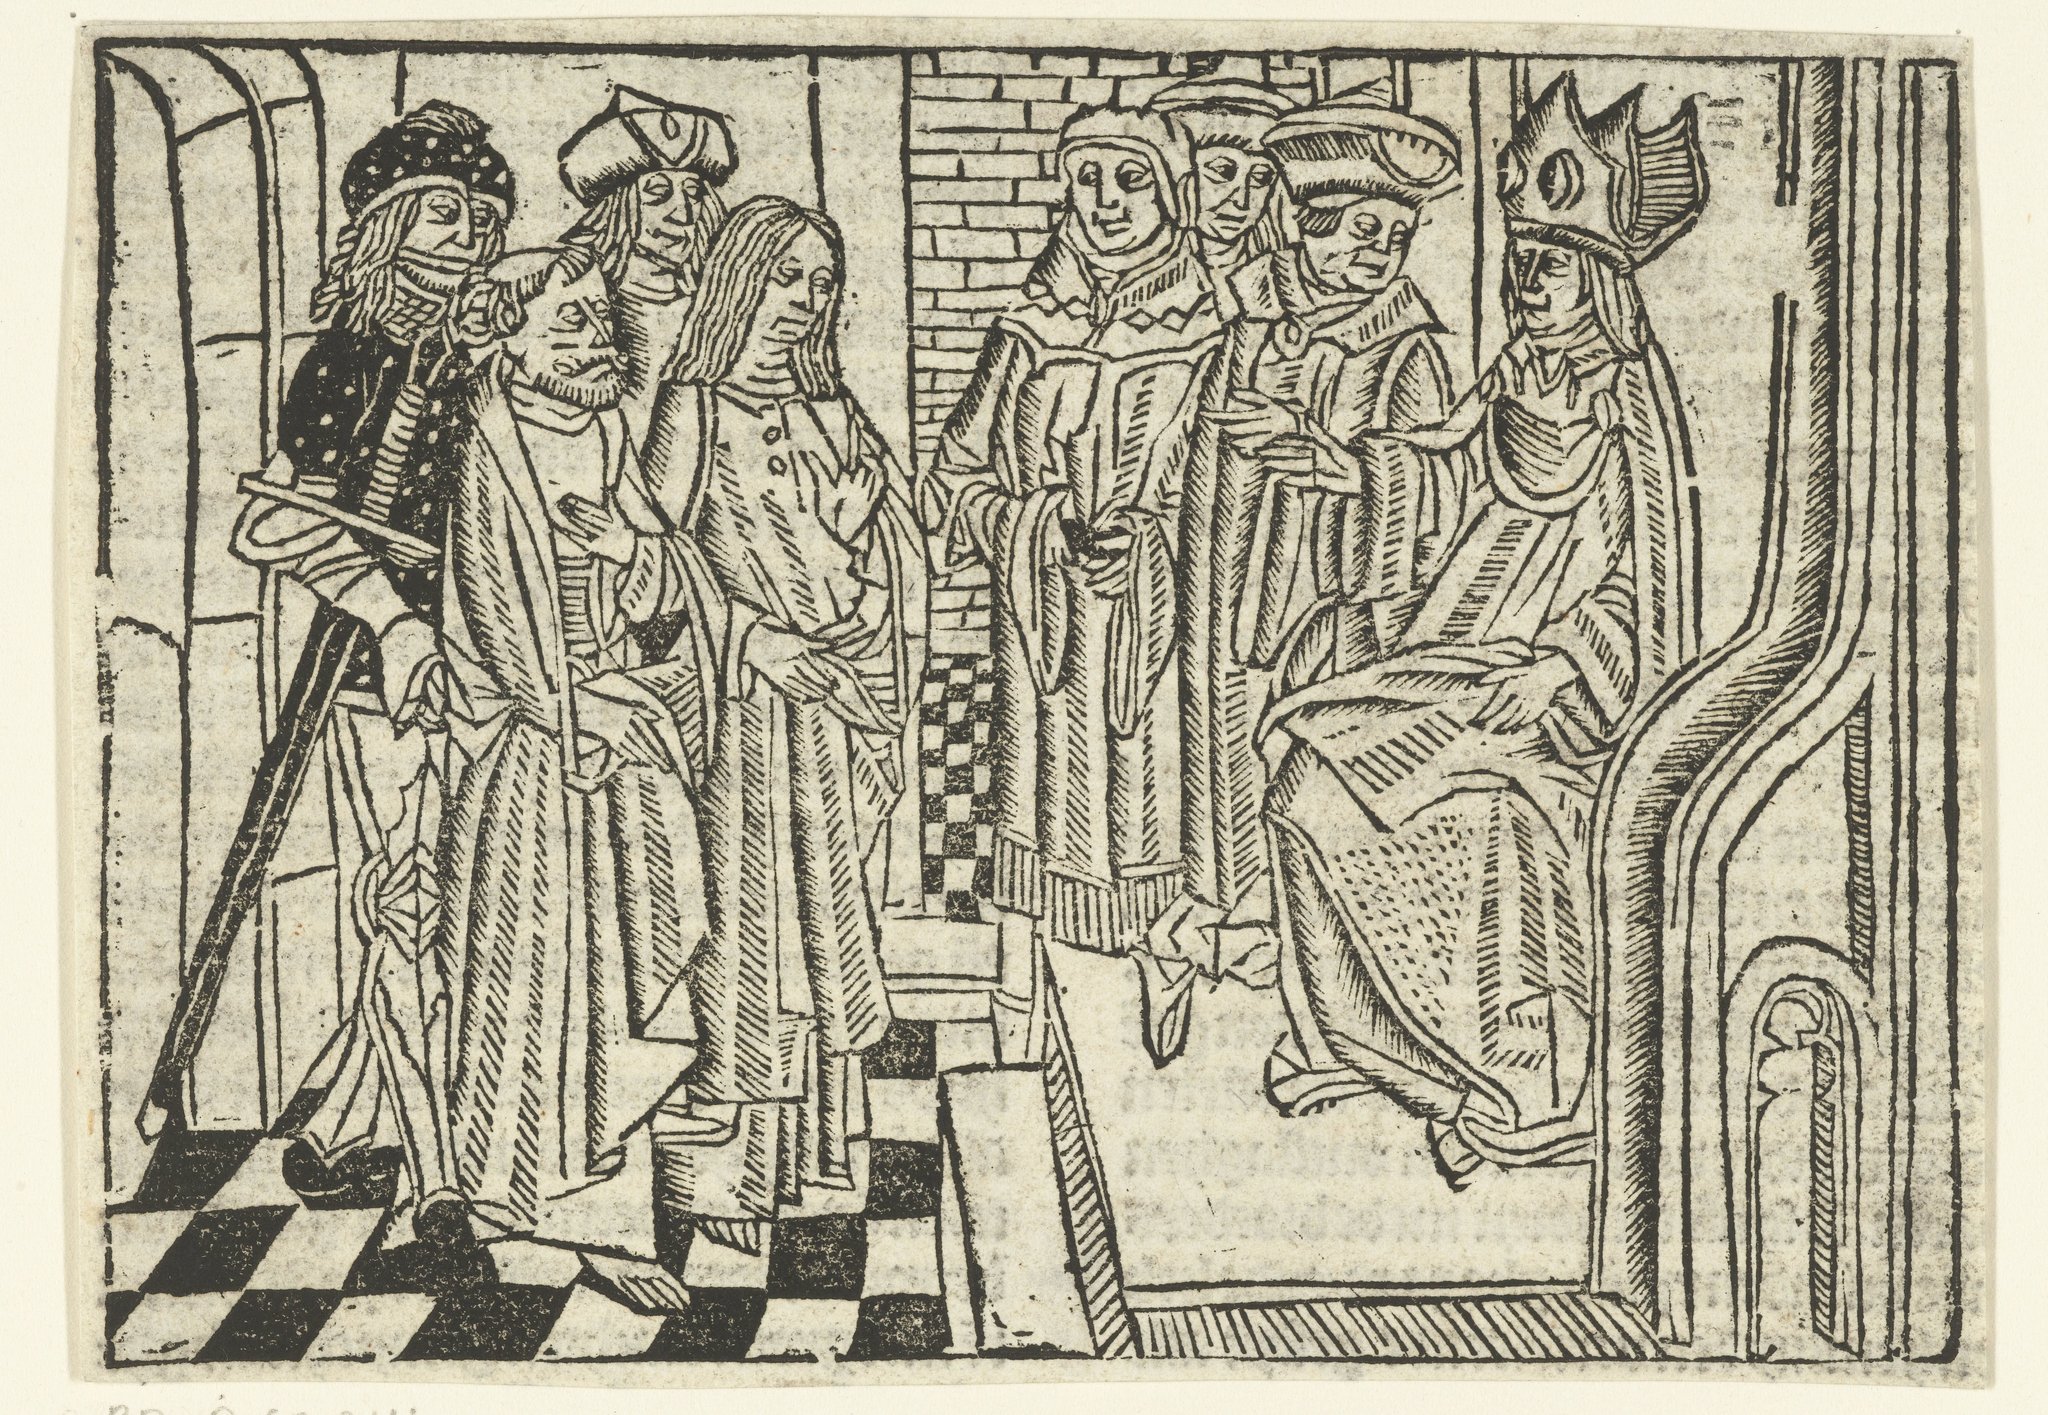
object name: book illustration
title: Petrus en Johannes de evangelist voor de hogepriester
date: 1480-1500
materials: paper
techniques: woodcut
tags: the apostle john the evangelist; possible attributes: book, cauldron, chalice with snake, eagle, palm, scroll, the apostle peter, first bishop of rome; possible attributes: book, cock, (upturned) cross, (triple) crozier, fish, key, scroll, ship, tiara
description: Eén blad van 113 uit Ludolphus de Saxonia, "Dit es dleué ons liefs heeren ihesu christi". Anonieme Nederlandse vertaling. Uitgegeven door Henrick Eckert van Homberch te Antwerpen in 1503. Botke, K. Deze 113 houtsneden, die meestal reeds in vroege Nederlandse boeken gebruikt zijn, worden toegeschreven aan de tweede Meester van Delft, de Meester van de Delbecq-Schreiber-passie en de Meester van de Virgo inter Virgines. In Conway (1884) en in "De gulden passer"(1951) zijn ook eerdere versies opgenomen. Botke, K.